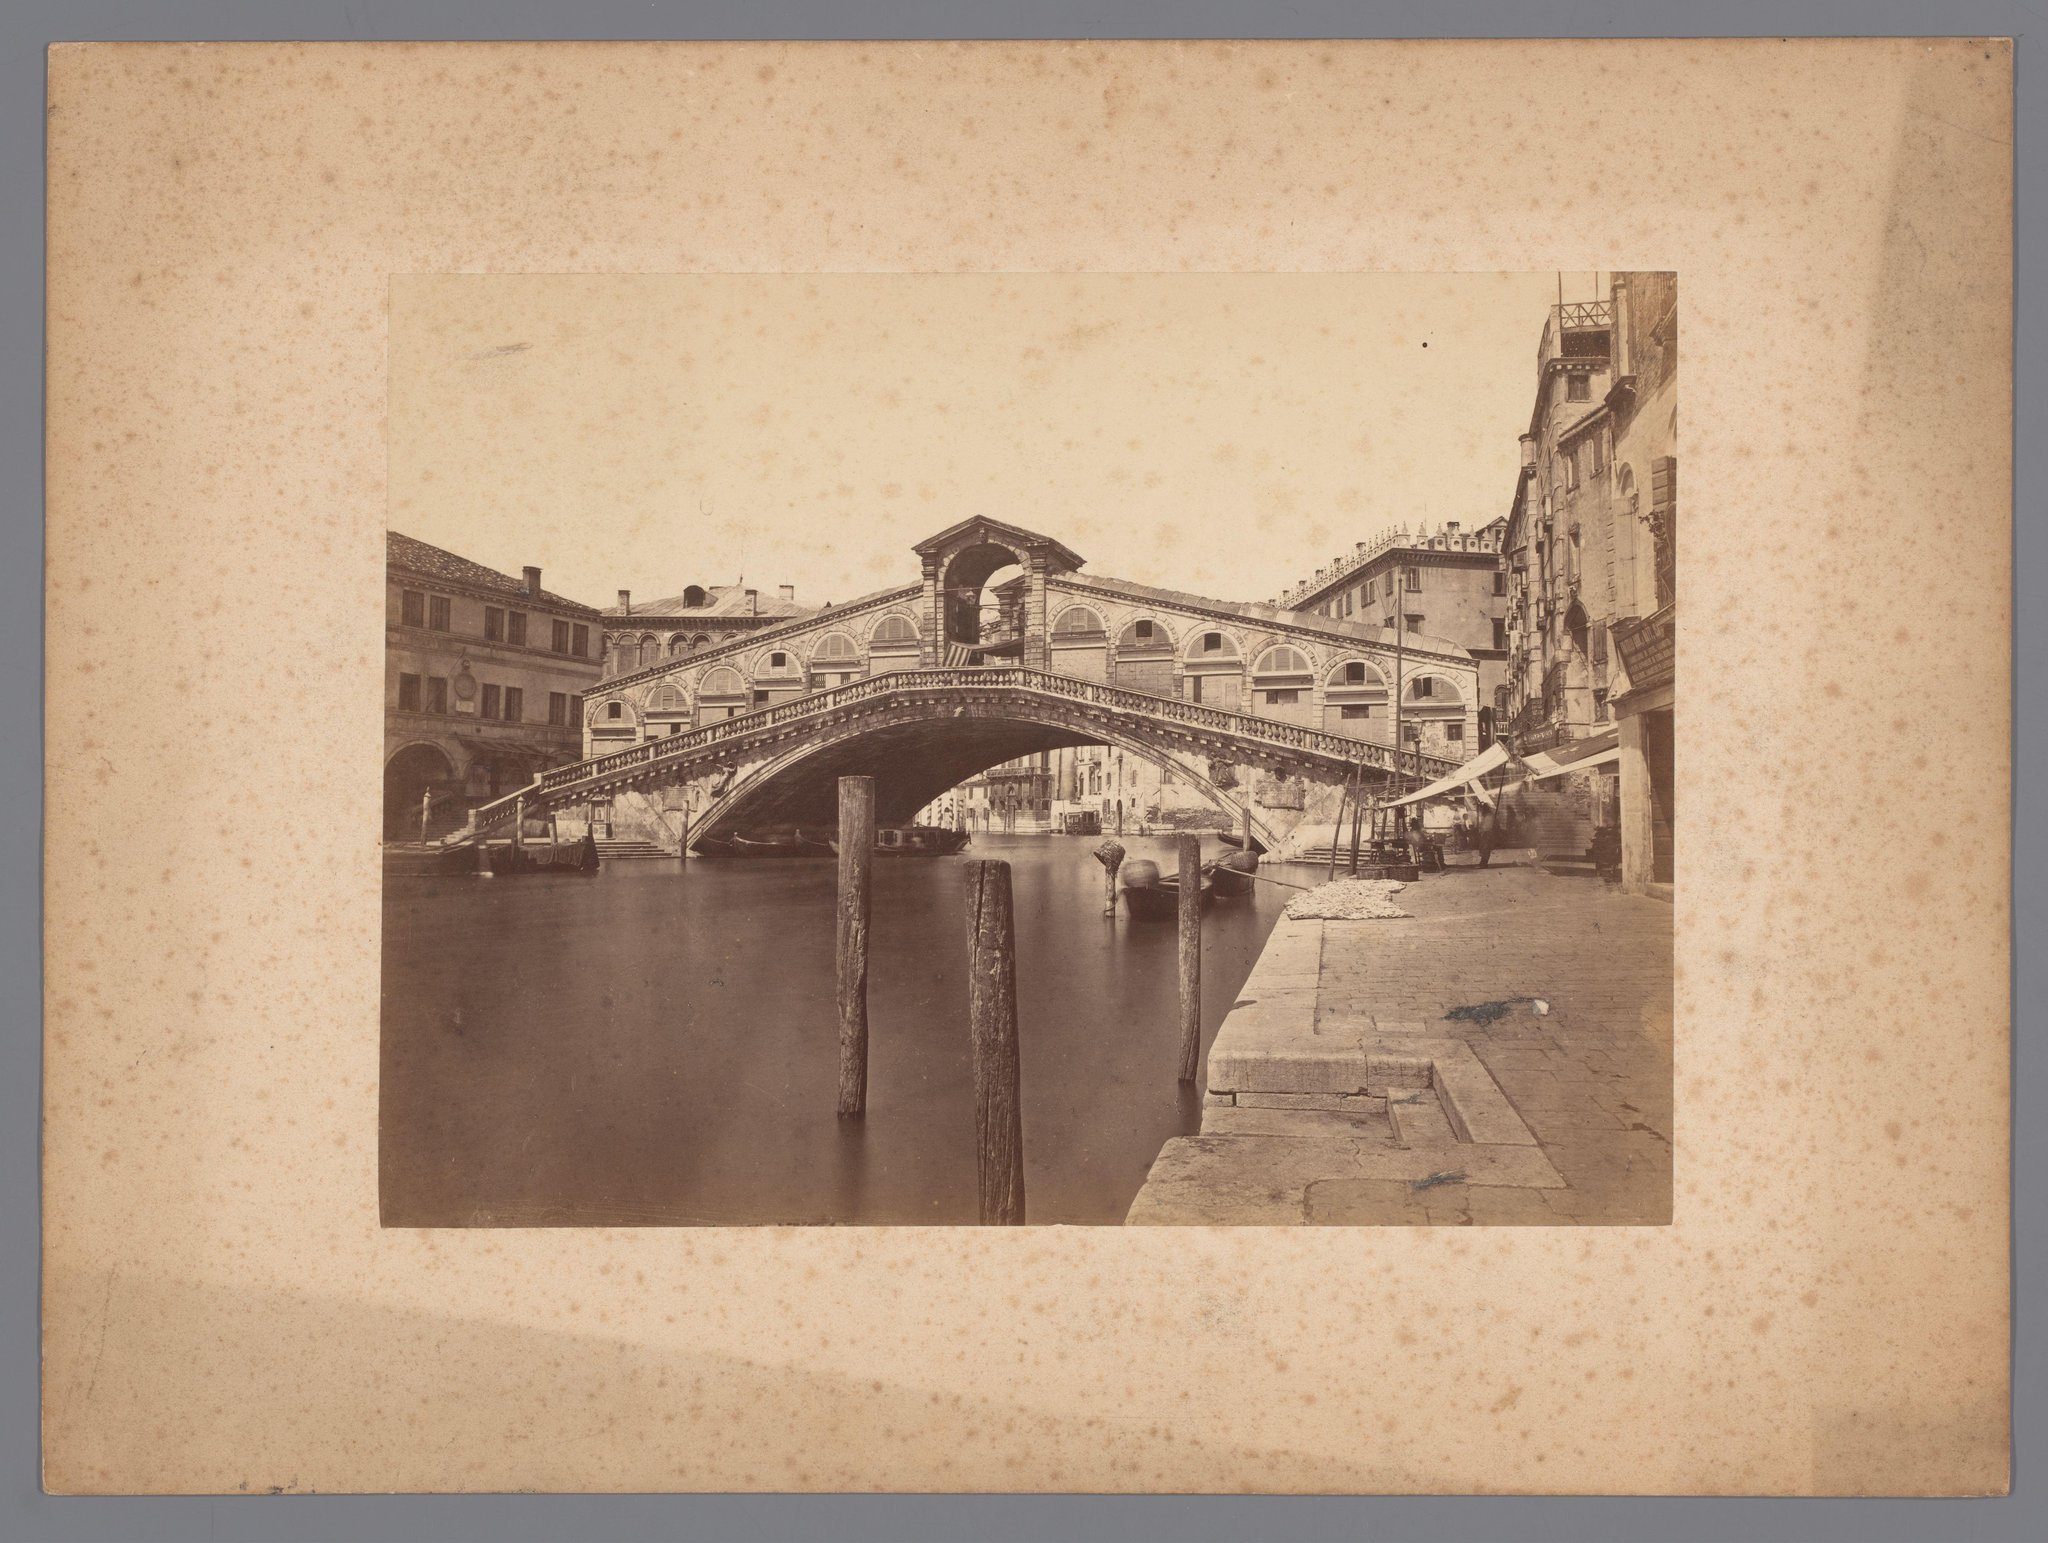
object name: photograph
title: Ponte Rialto, Venetië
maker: Anonymous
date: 1872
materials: cardboard, paper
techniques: albumen print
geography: venice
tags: bridge in city across river, canal, etc.